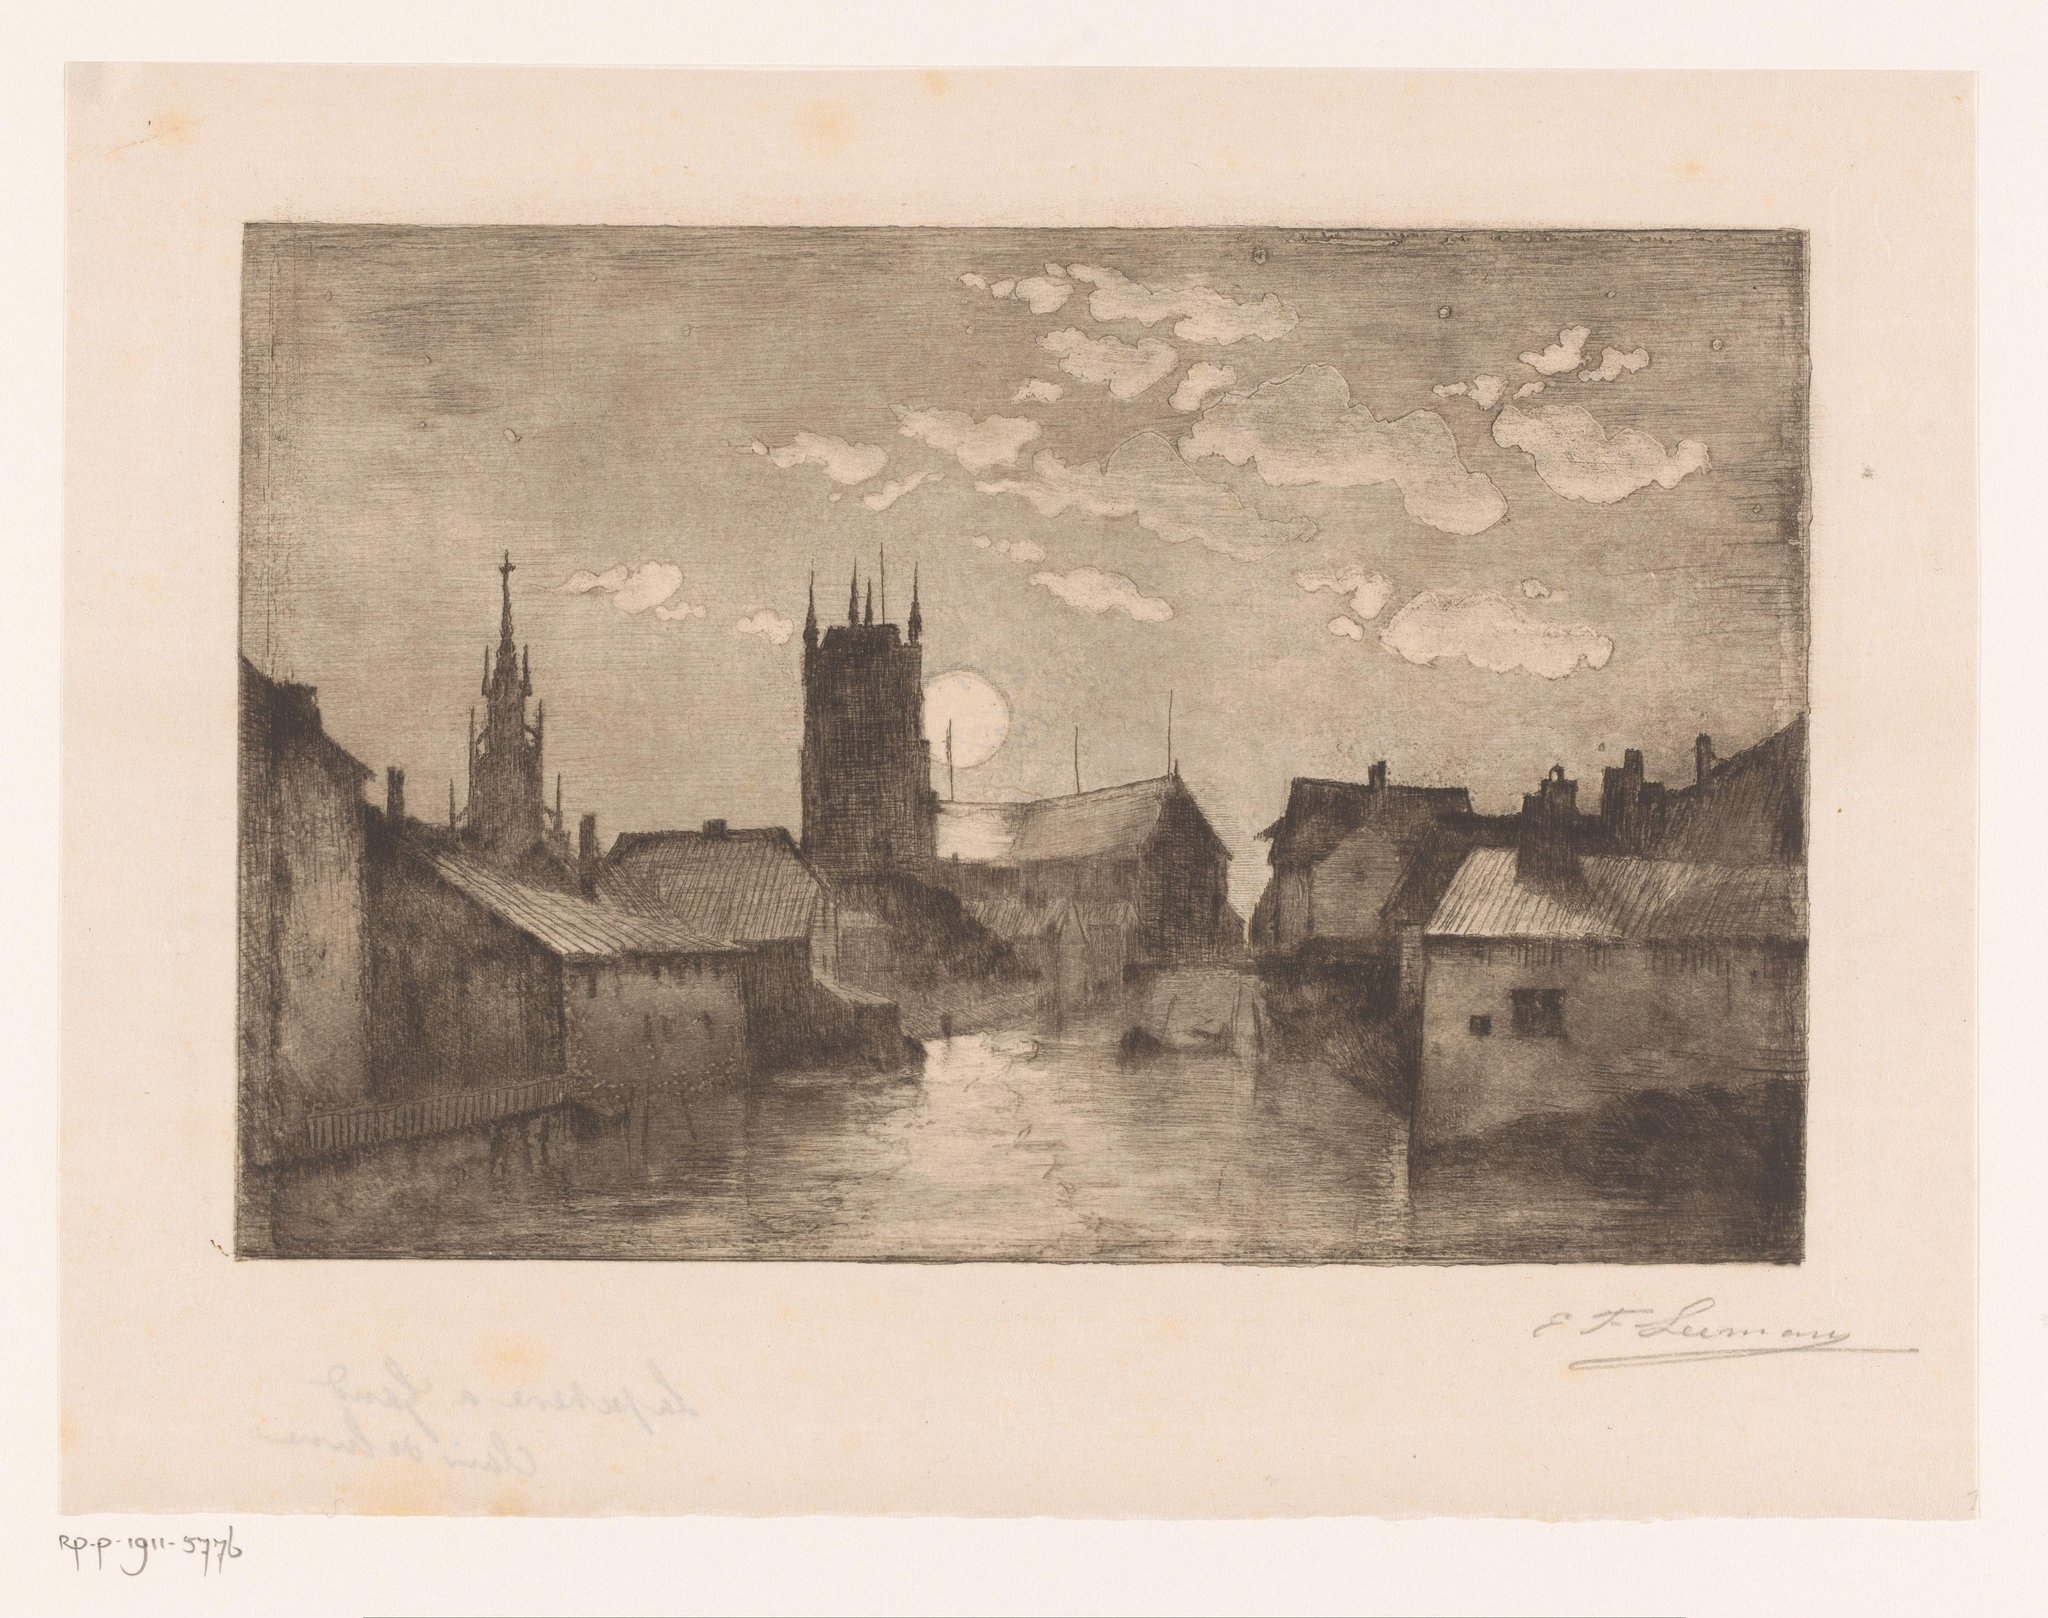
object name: print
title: Riviergezicht in Gent bij maanlicht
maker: egide françois leemans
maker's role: print maker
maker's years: 1839-1883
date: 1849-1883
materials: paper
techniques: aquatint, etching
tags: church (exterior), canals, waters (in city), ghent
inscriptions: workshop stamp: ‘Antwerpsche Etsers 1880’, collector's mark: Lugt 2228